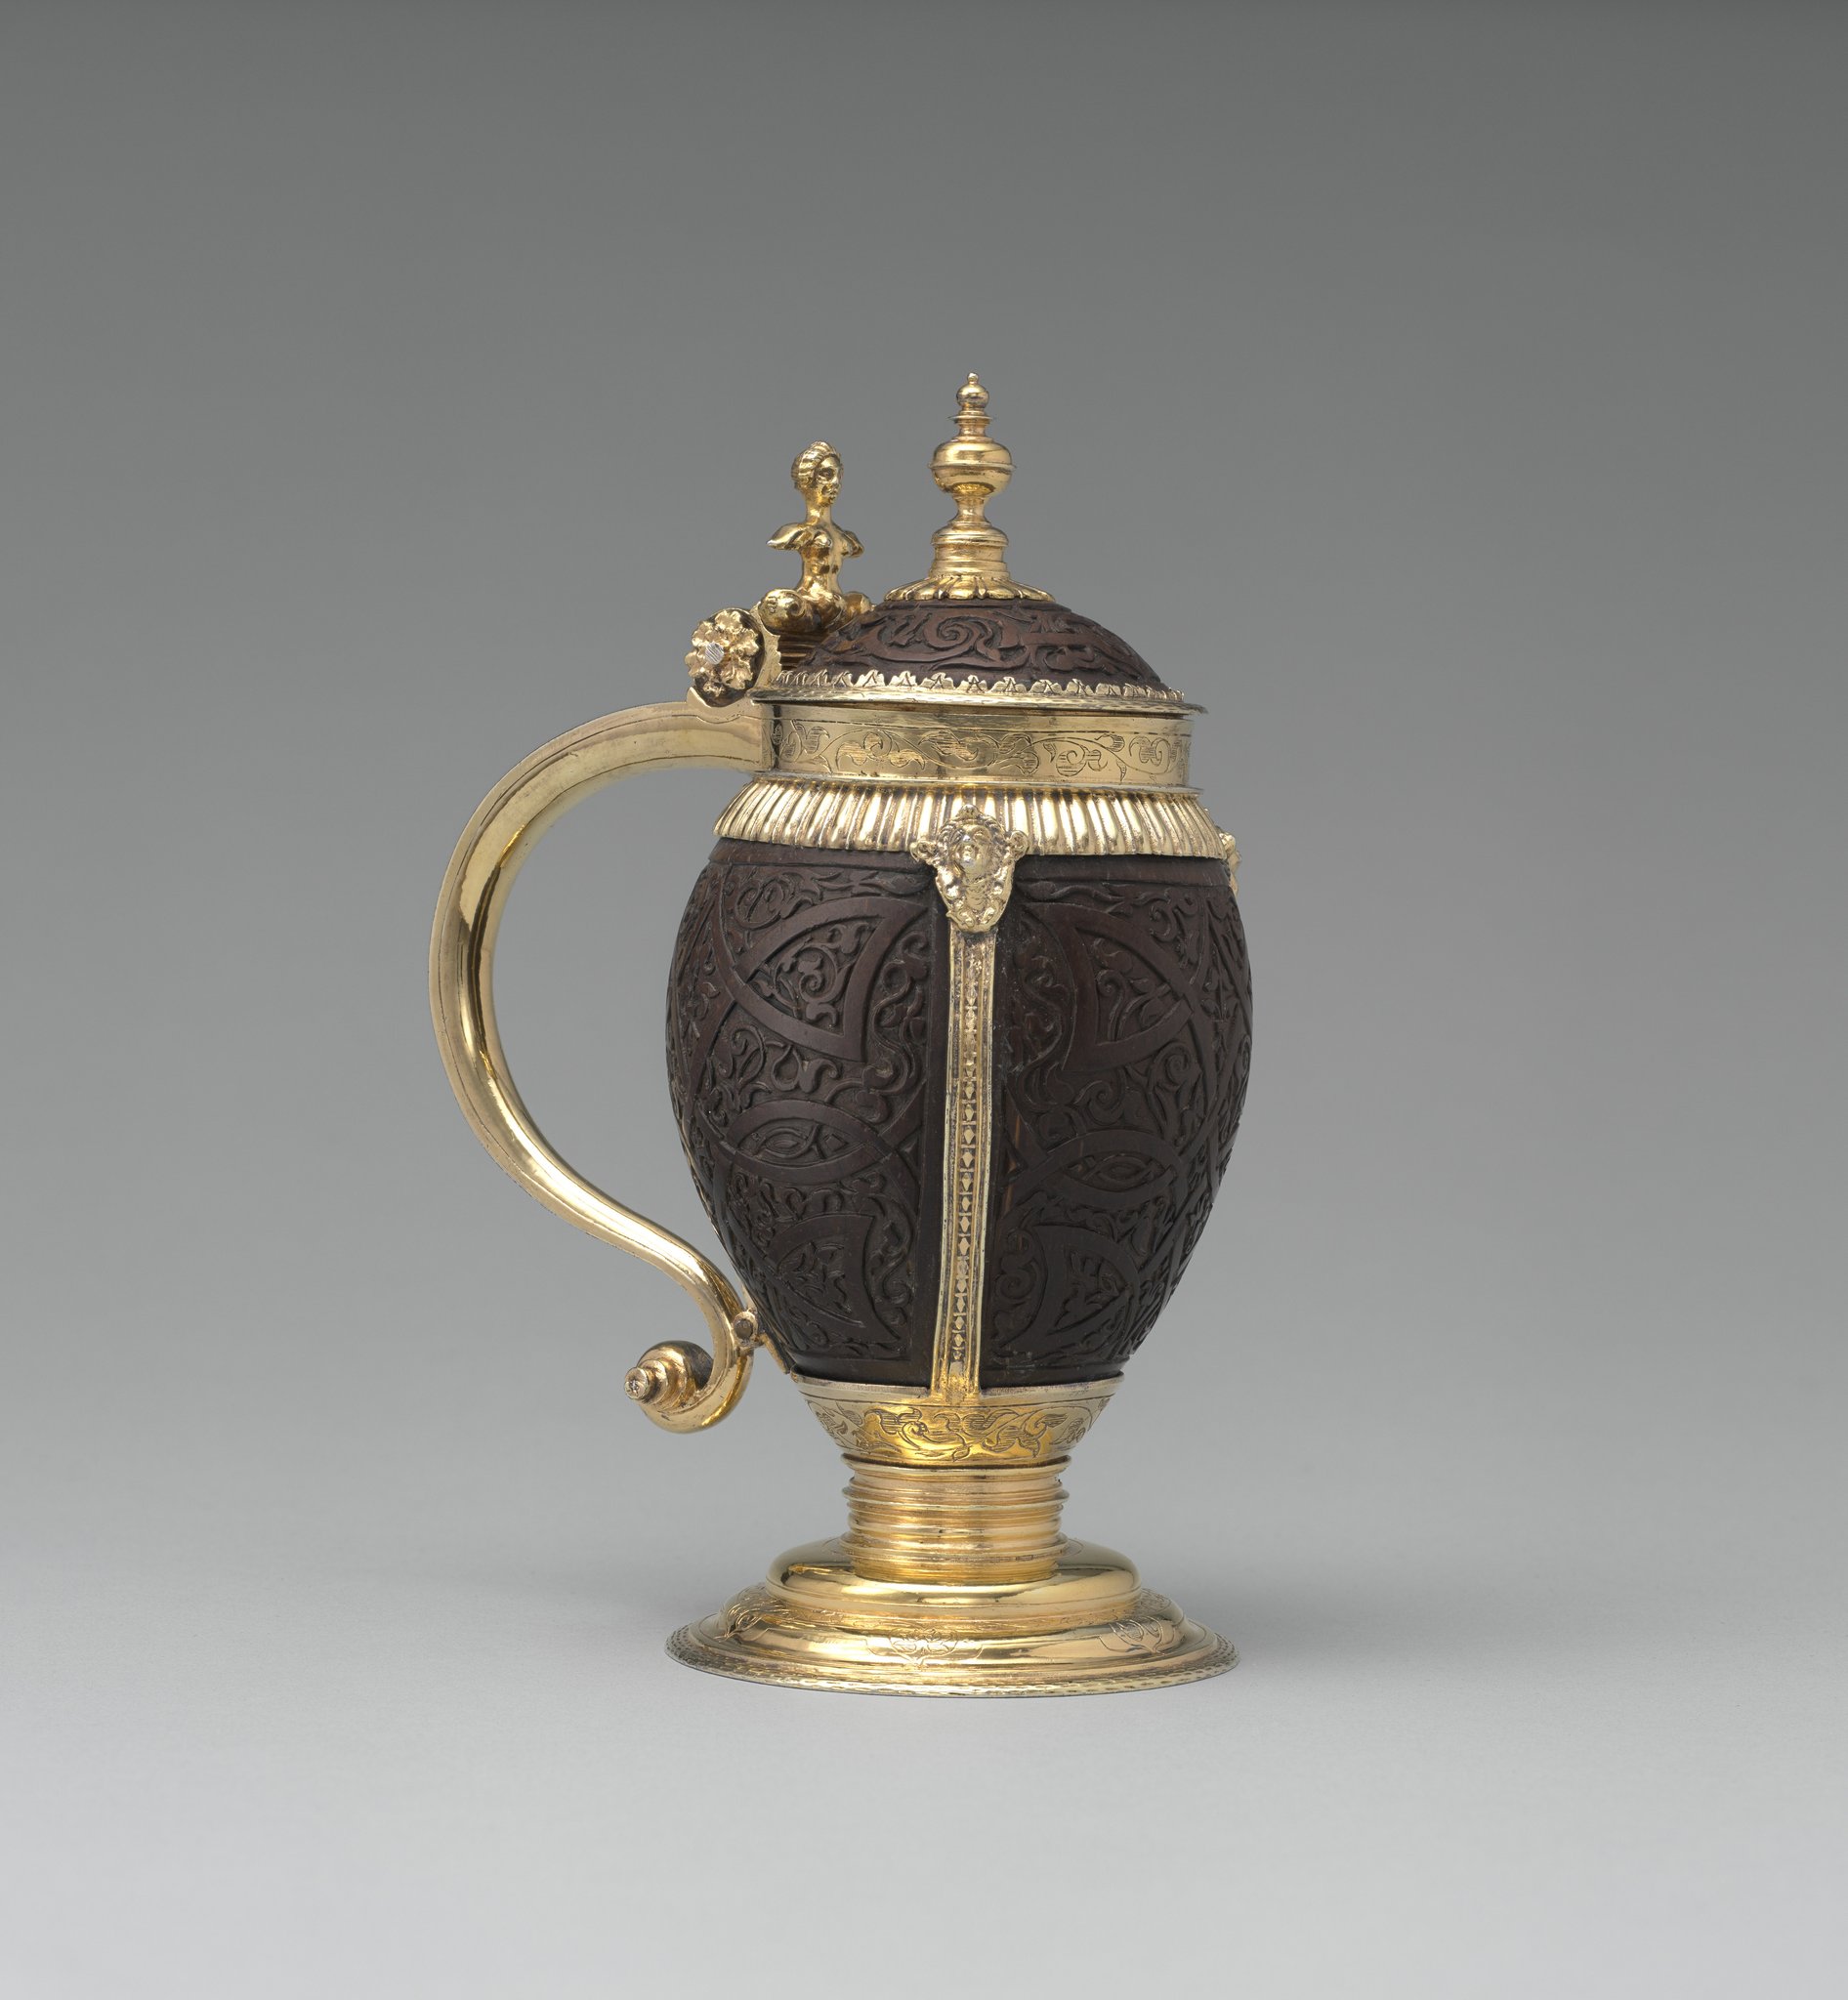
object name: tankard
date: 1600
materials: gilt silver